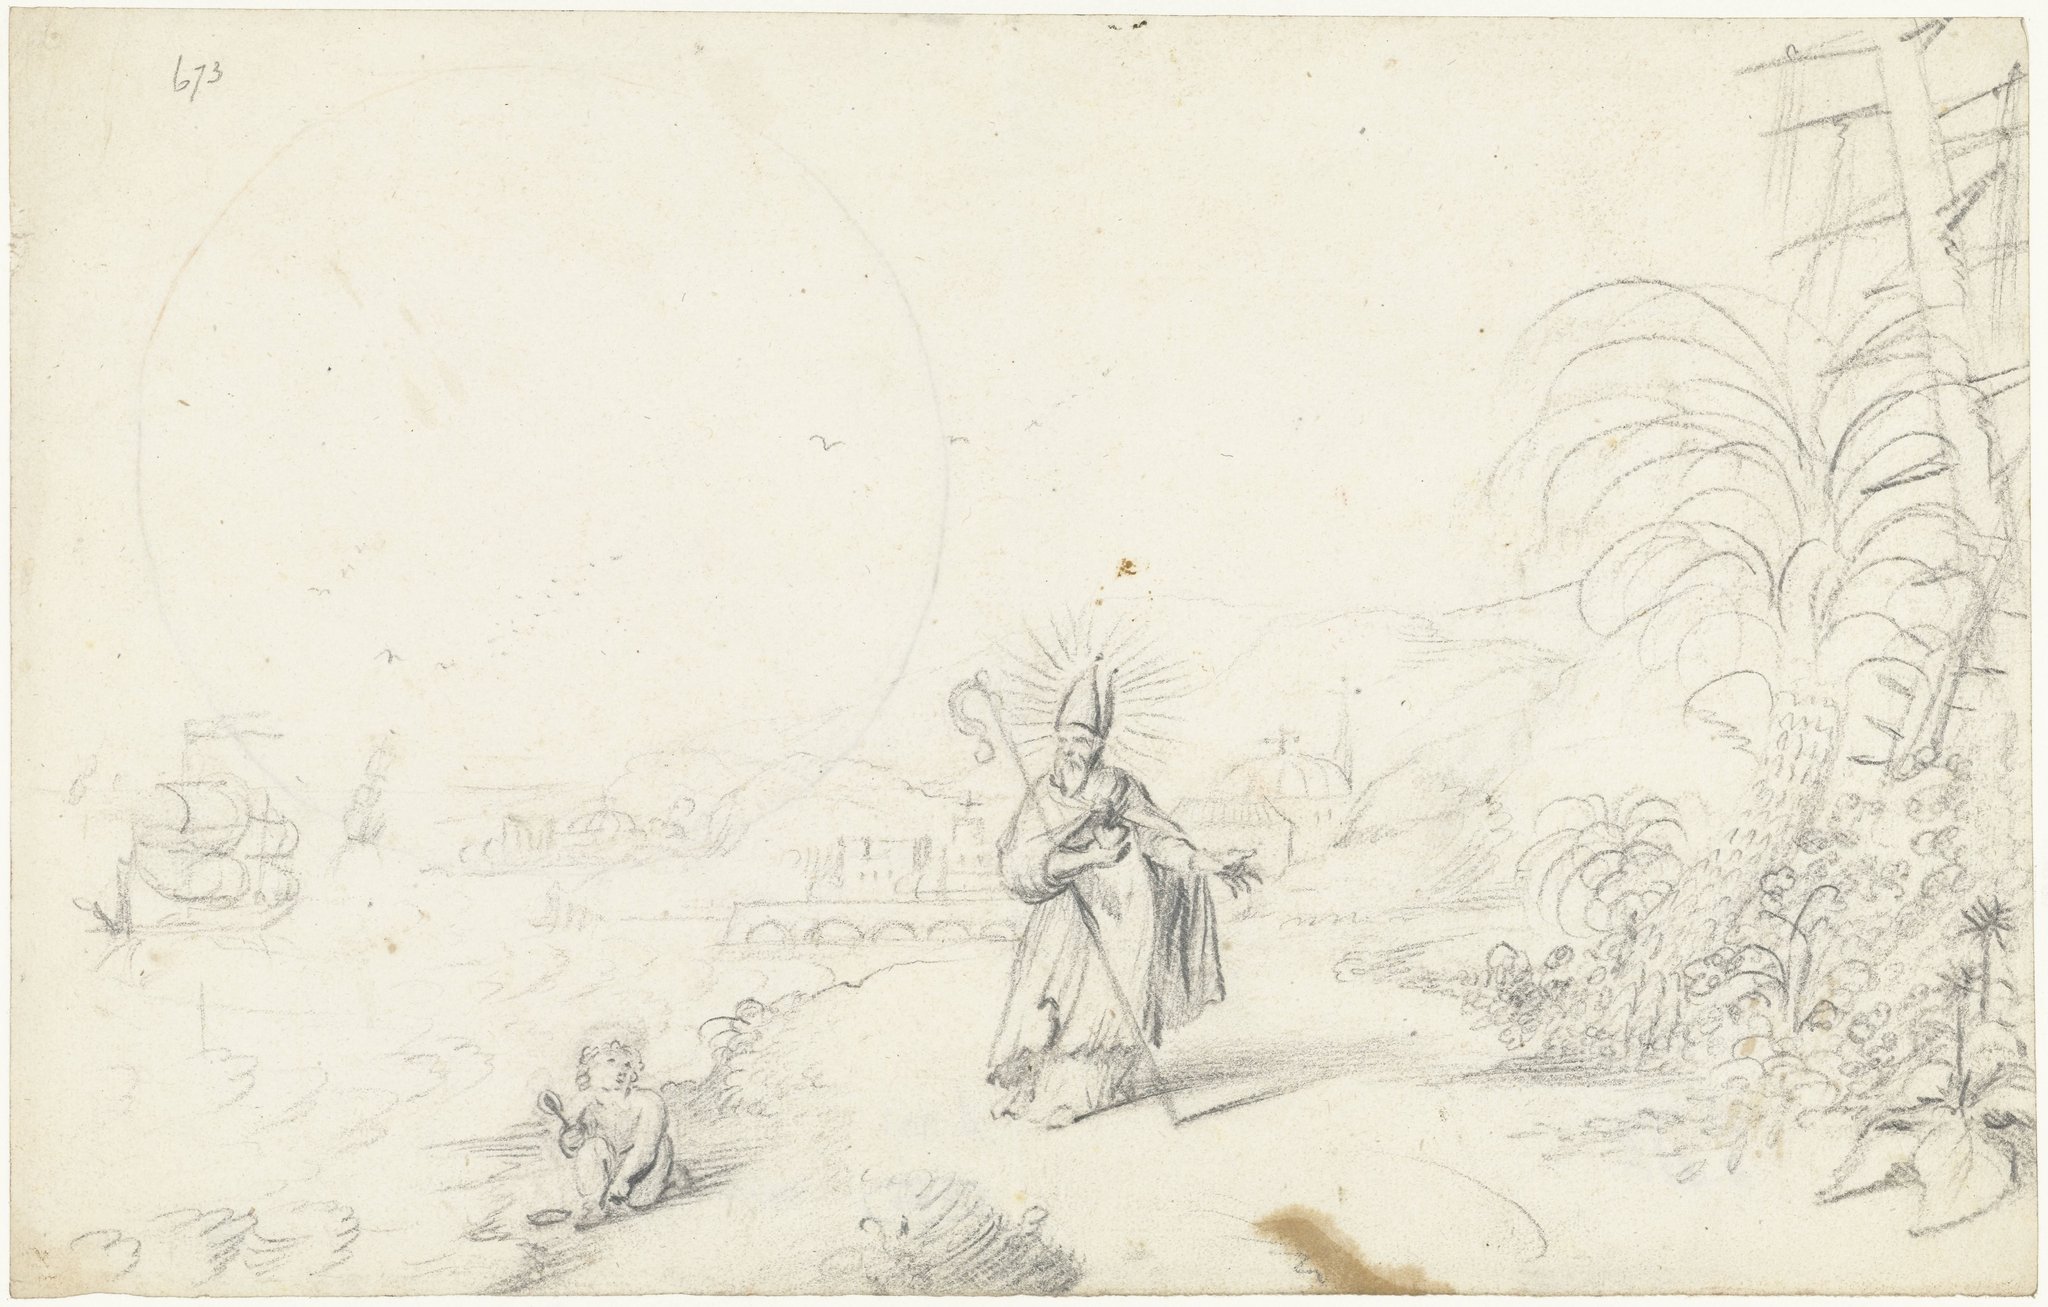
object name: drawing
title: Heilige Augustinus en het kind aan zee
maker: gesina ter borch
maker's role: draughtsman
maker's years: 1633-1690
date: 1660-1661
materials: paper, pencil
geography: zwolle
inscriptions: annotation: ‘Gesina’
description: Heilige Augustinus en het kind aan zee; op verso een cirkel.